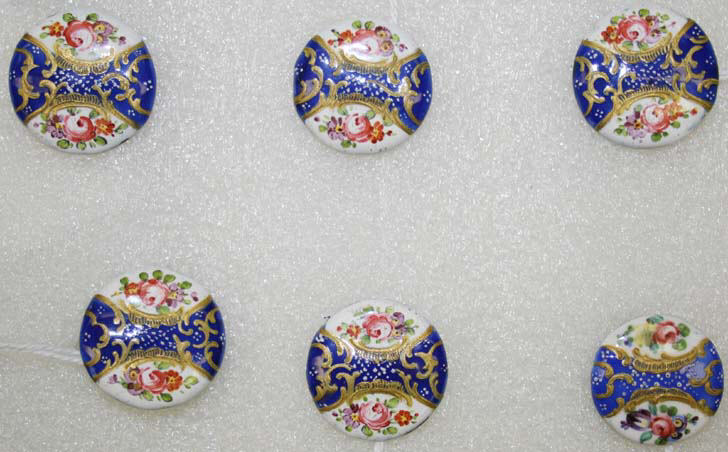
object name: button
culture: british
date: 1770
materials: enamel